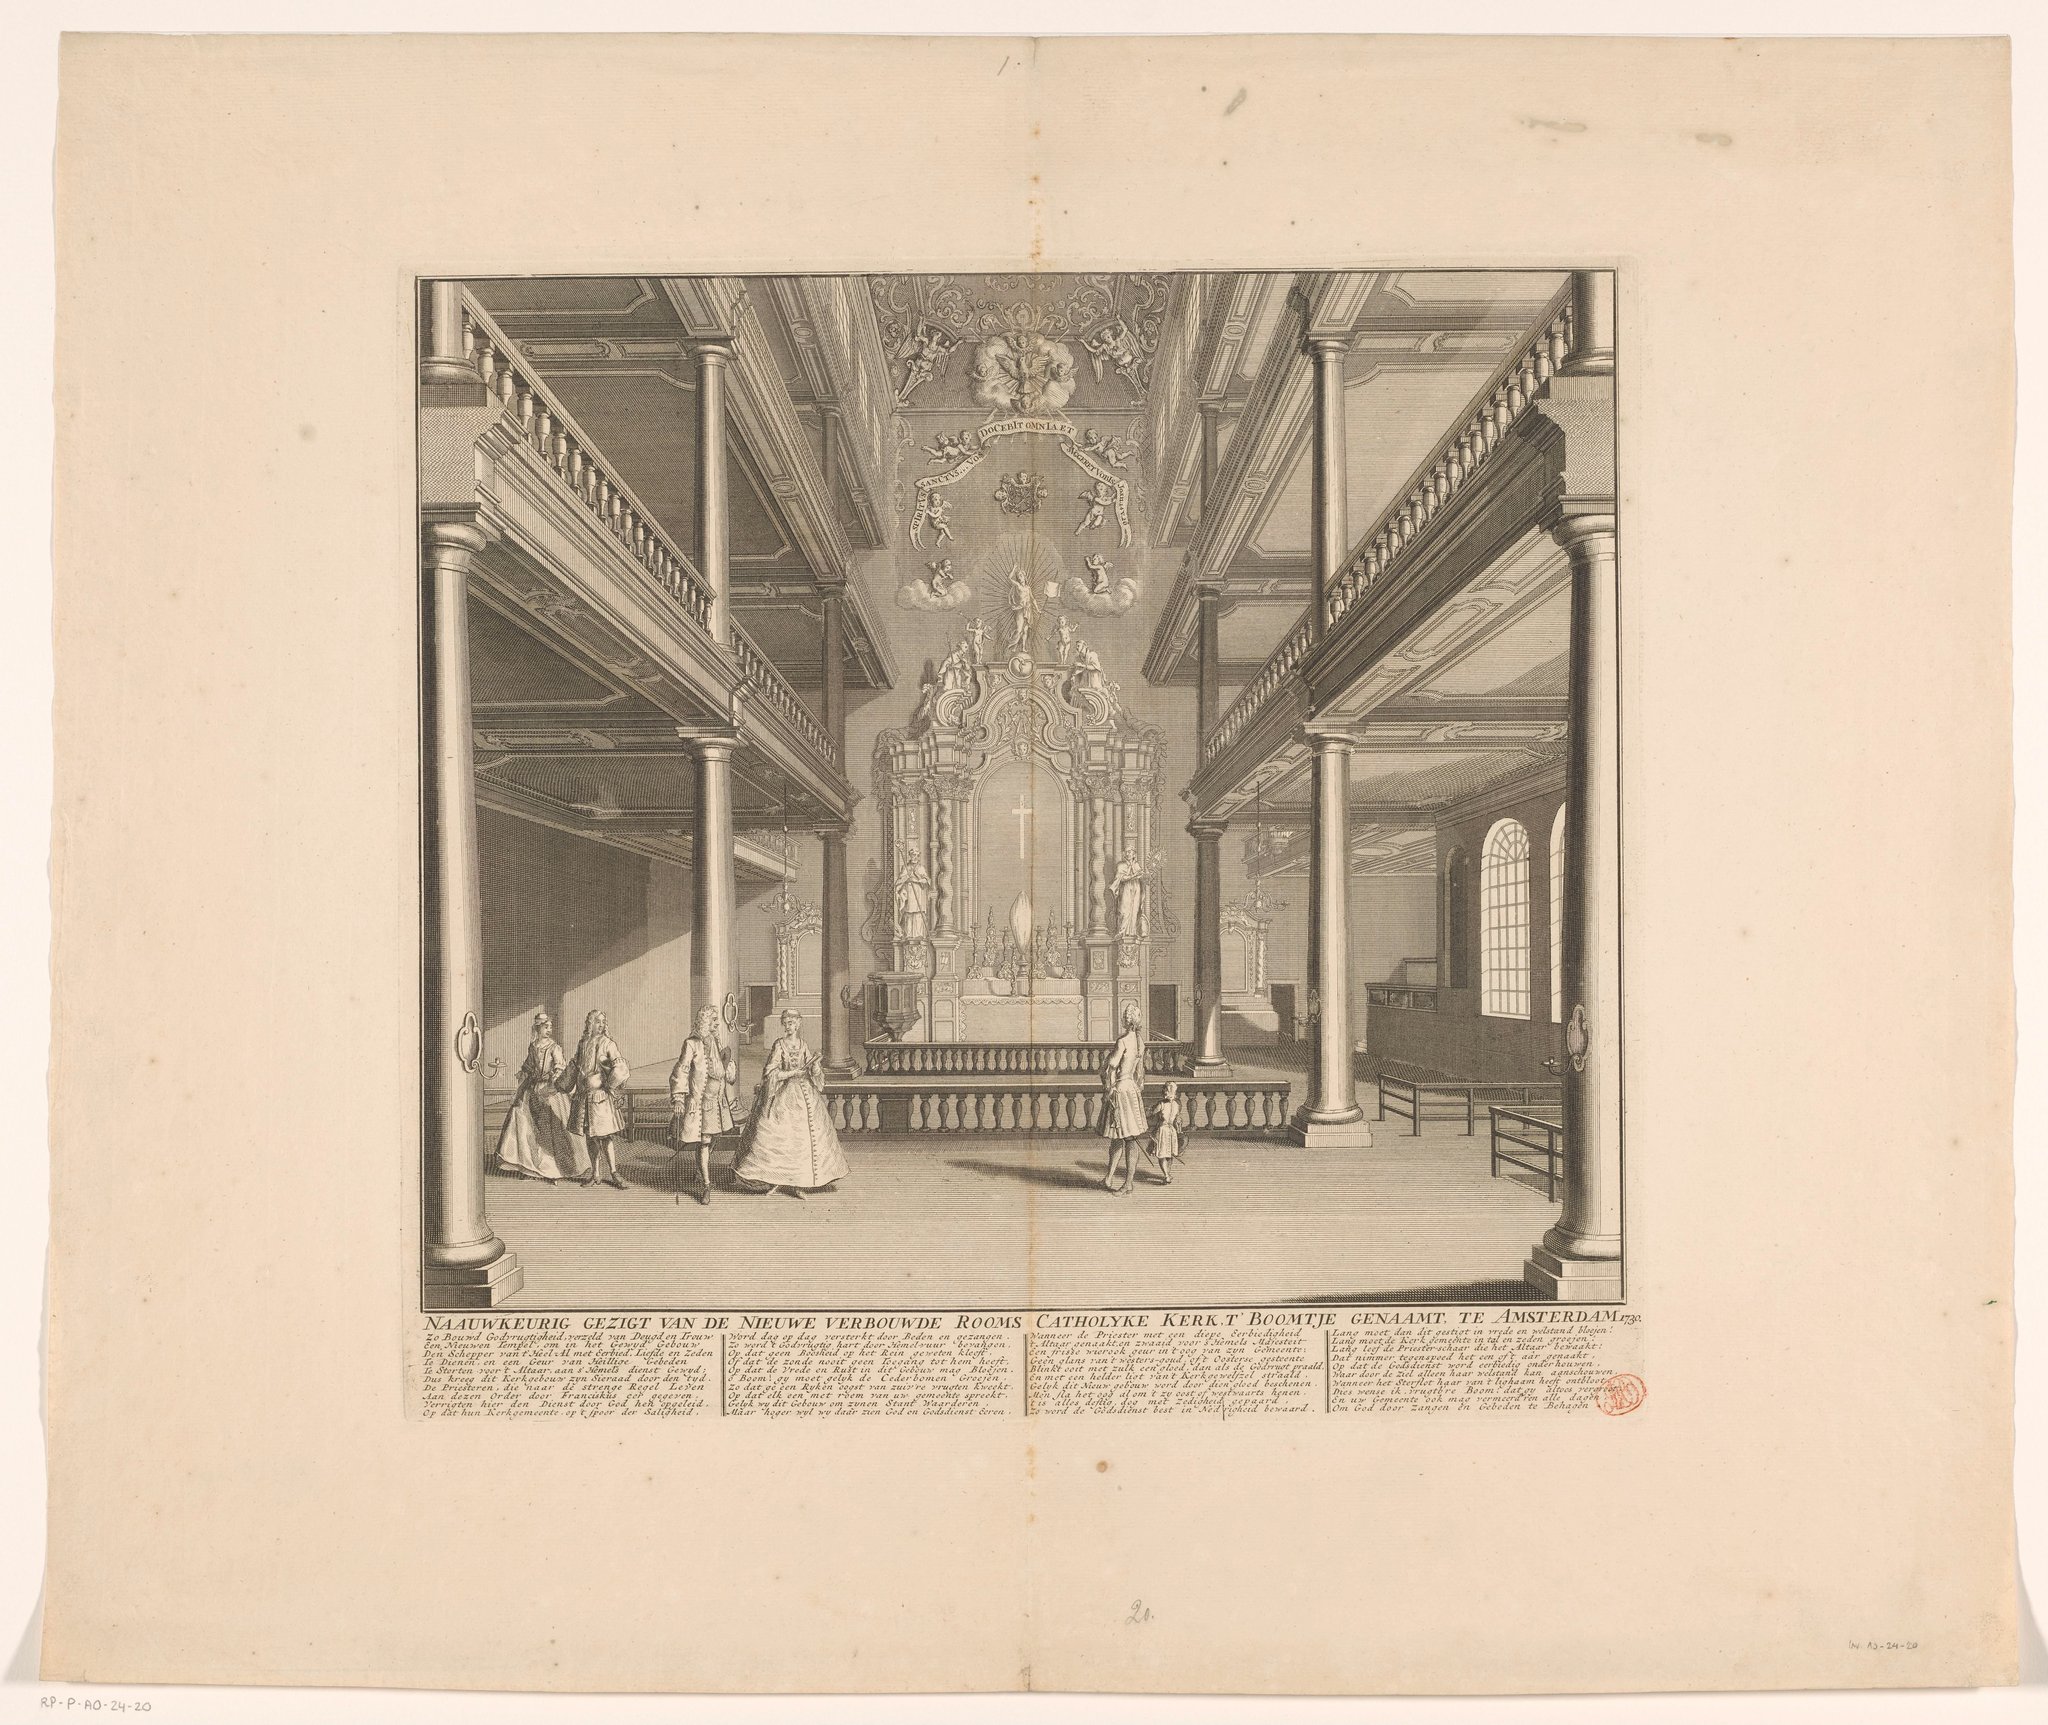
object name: print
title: Interieur van de rooms-katholieke schuilkerk Het Boompje te Amsterdam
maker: Anonymous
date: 1730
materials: paper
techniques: engraving, etching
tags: interior of church, altar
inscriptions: collector's mark: Lugt 195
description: Interieur van de rooms-katholieke schuilkerk Het Boompje, tussen de Kalverstraat en het Rokin, zoals het eruitzag na de in 1730 voltooide verbouwing. In het midden het altaar, in de kerk een aantal figuren. Onder de voorstelling een veertigregelig vers, verdeeld over vier kolommen.